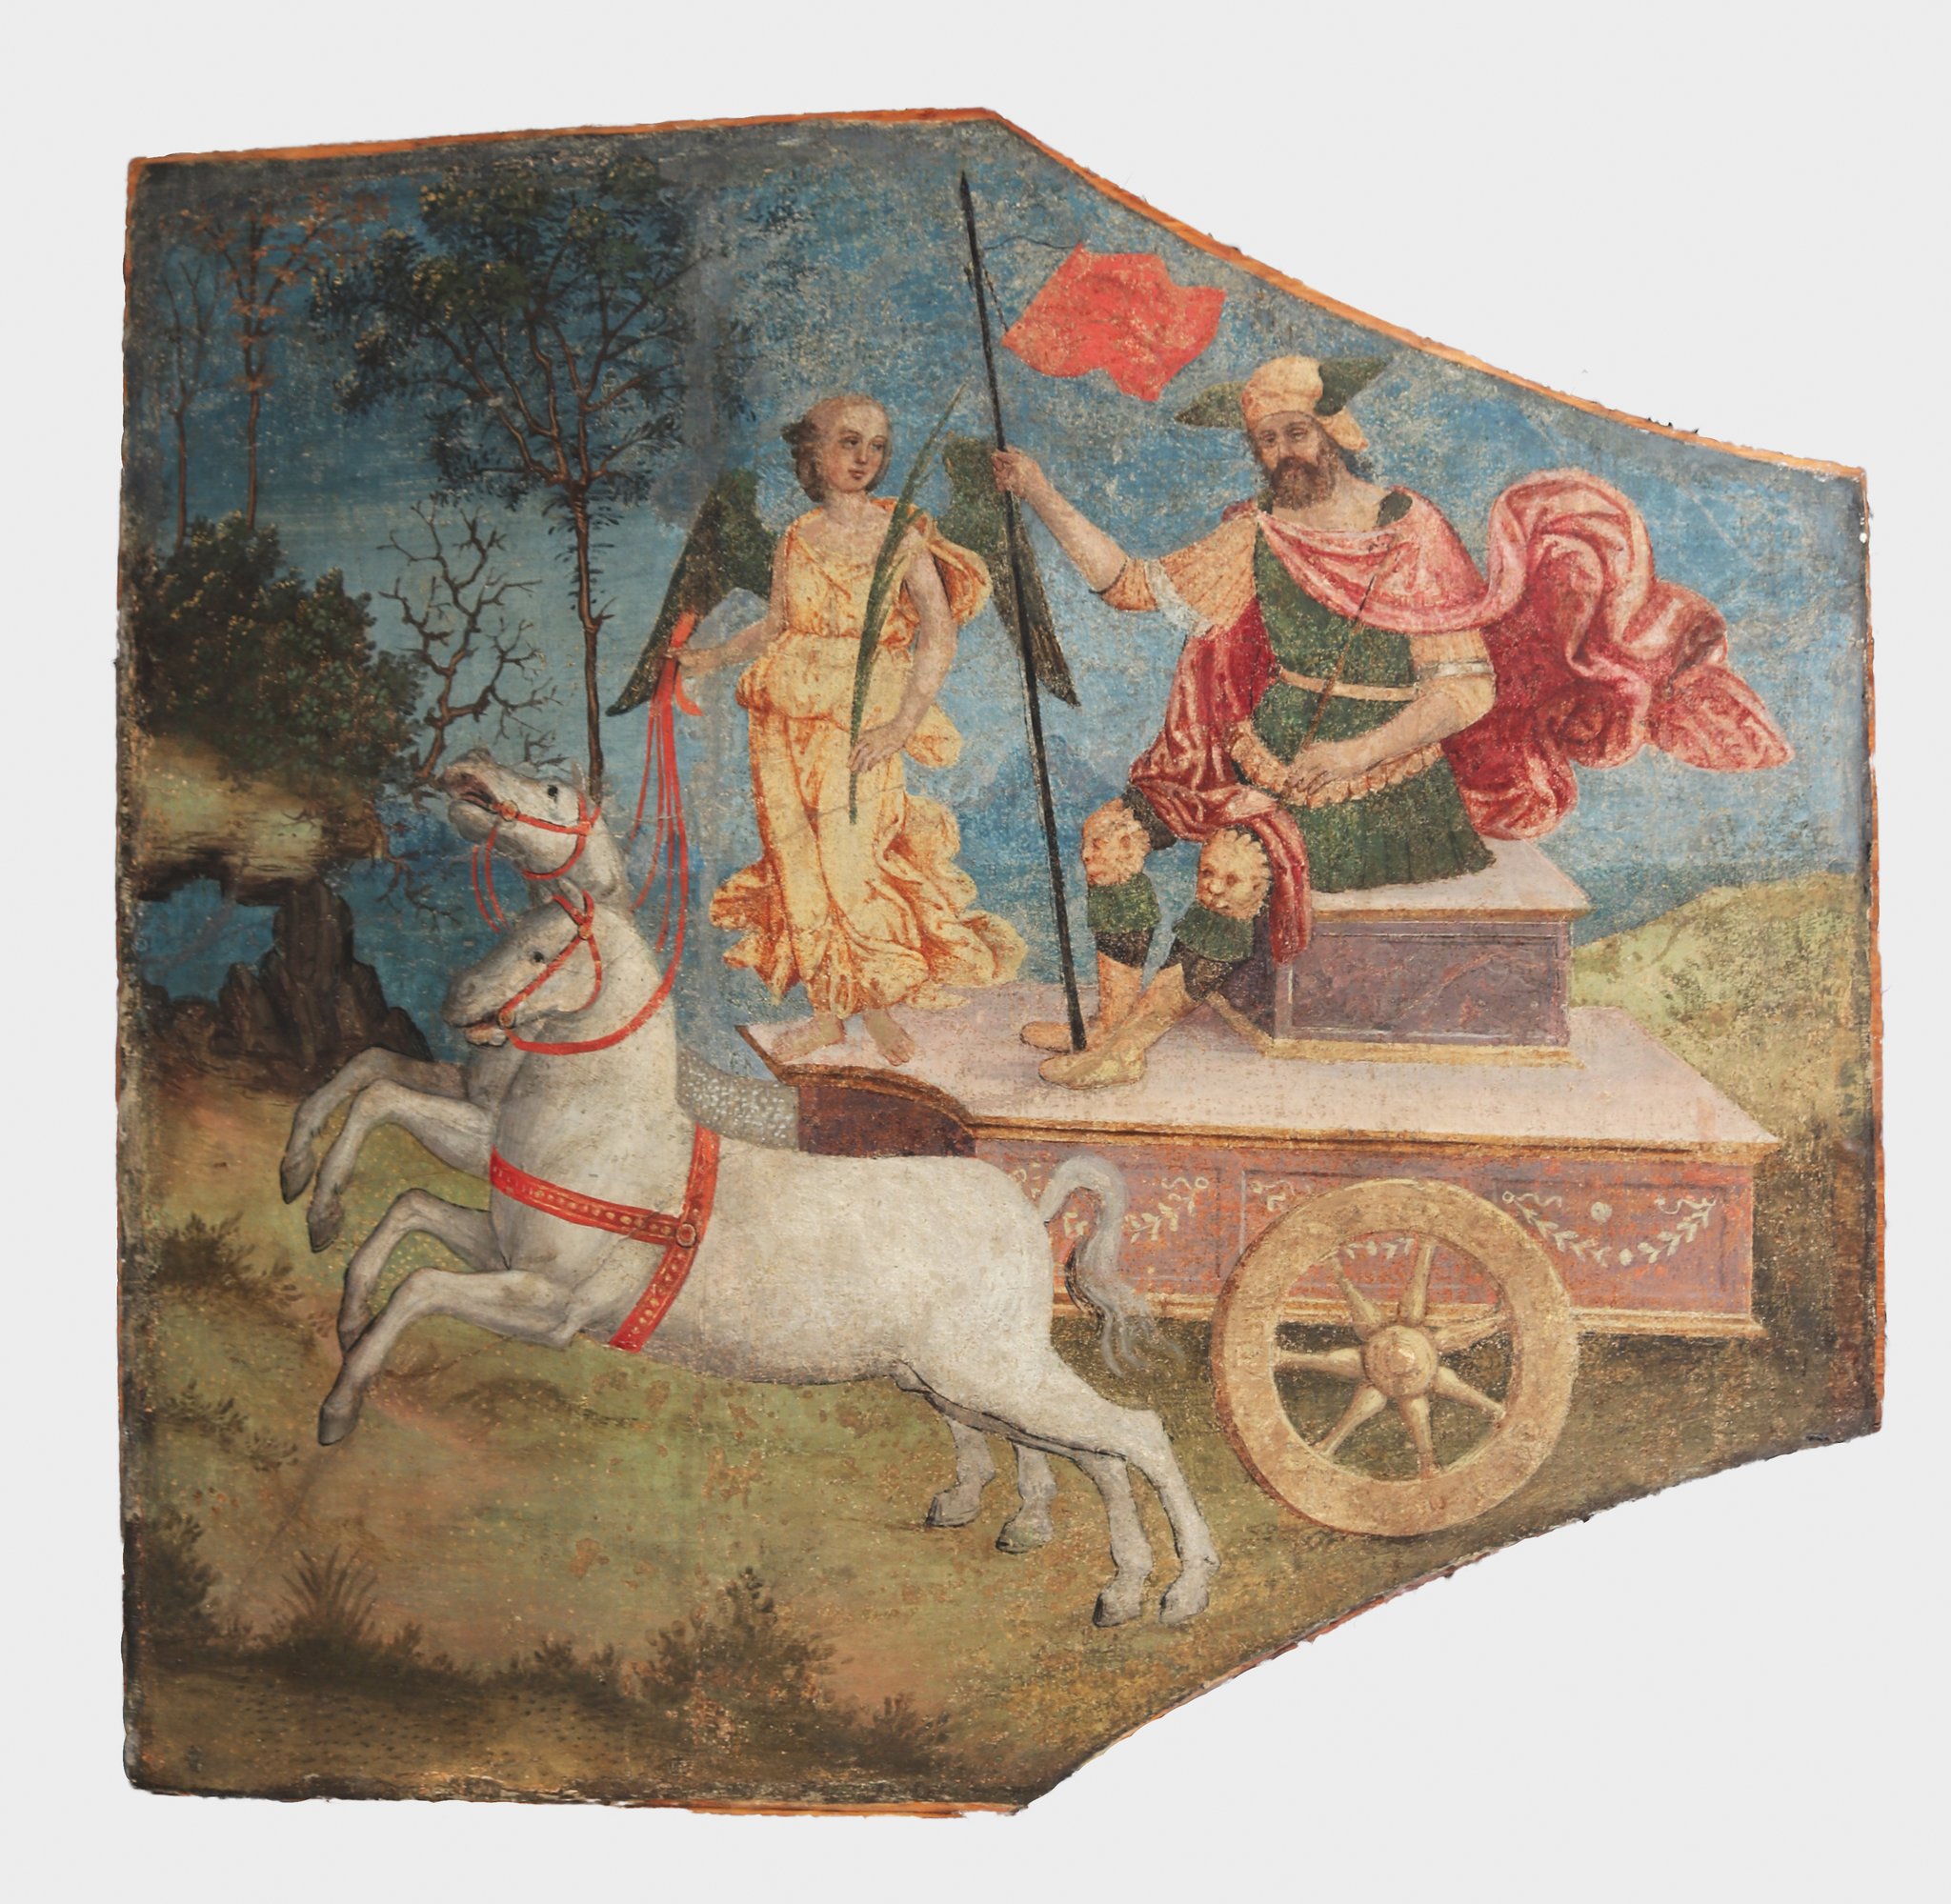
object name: ceiling panel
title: Triumph of Mars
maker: pinturicchio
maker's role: artist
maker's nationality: italian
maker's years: 1454-1513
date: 1509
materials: canvas, panel, wood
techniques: fresco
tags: mars,horses,chariots